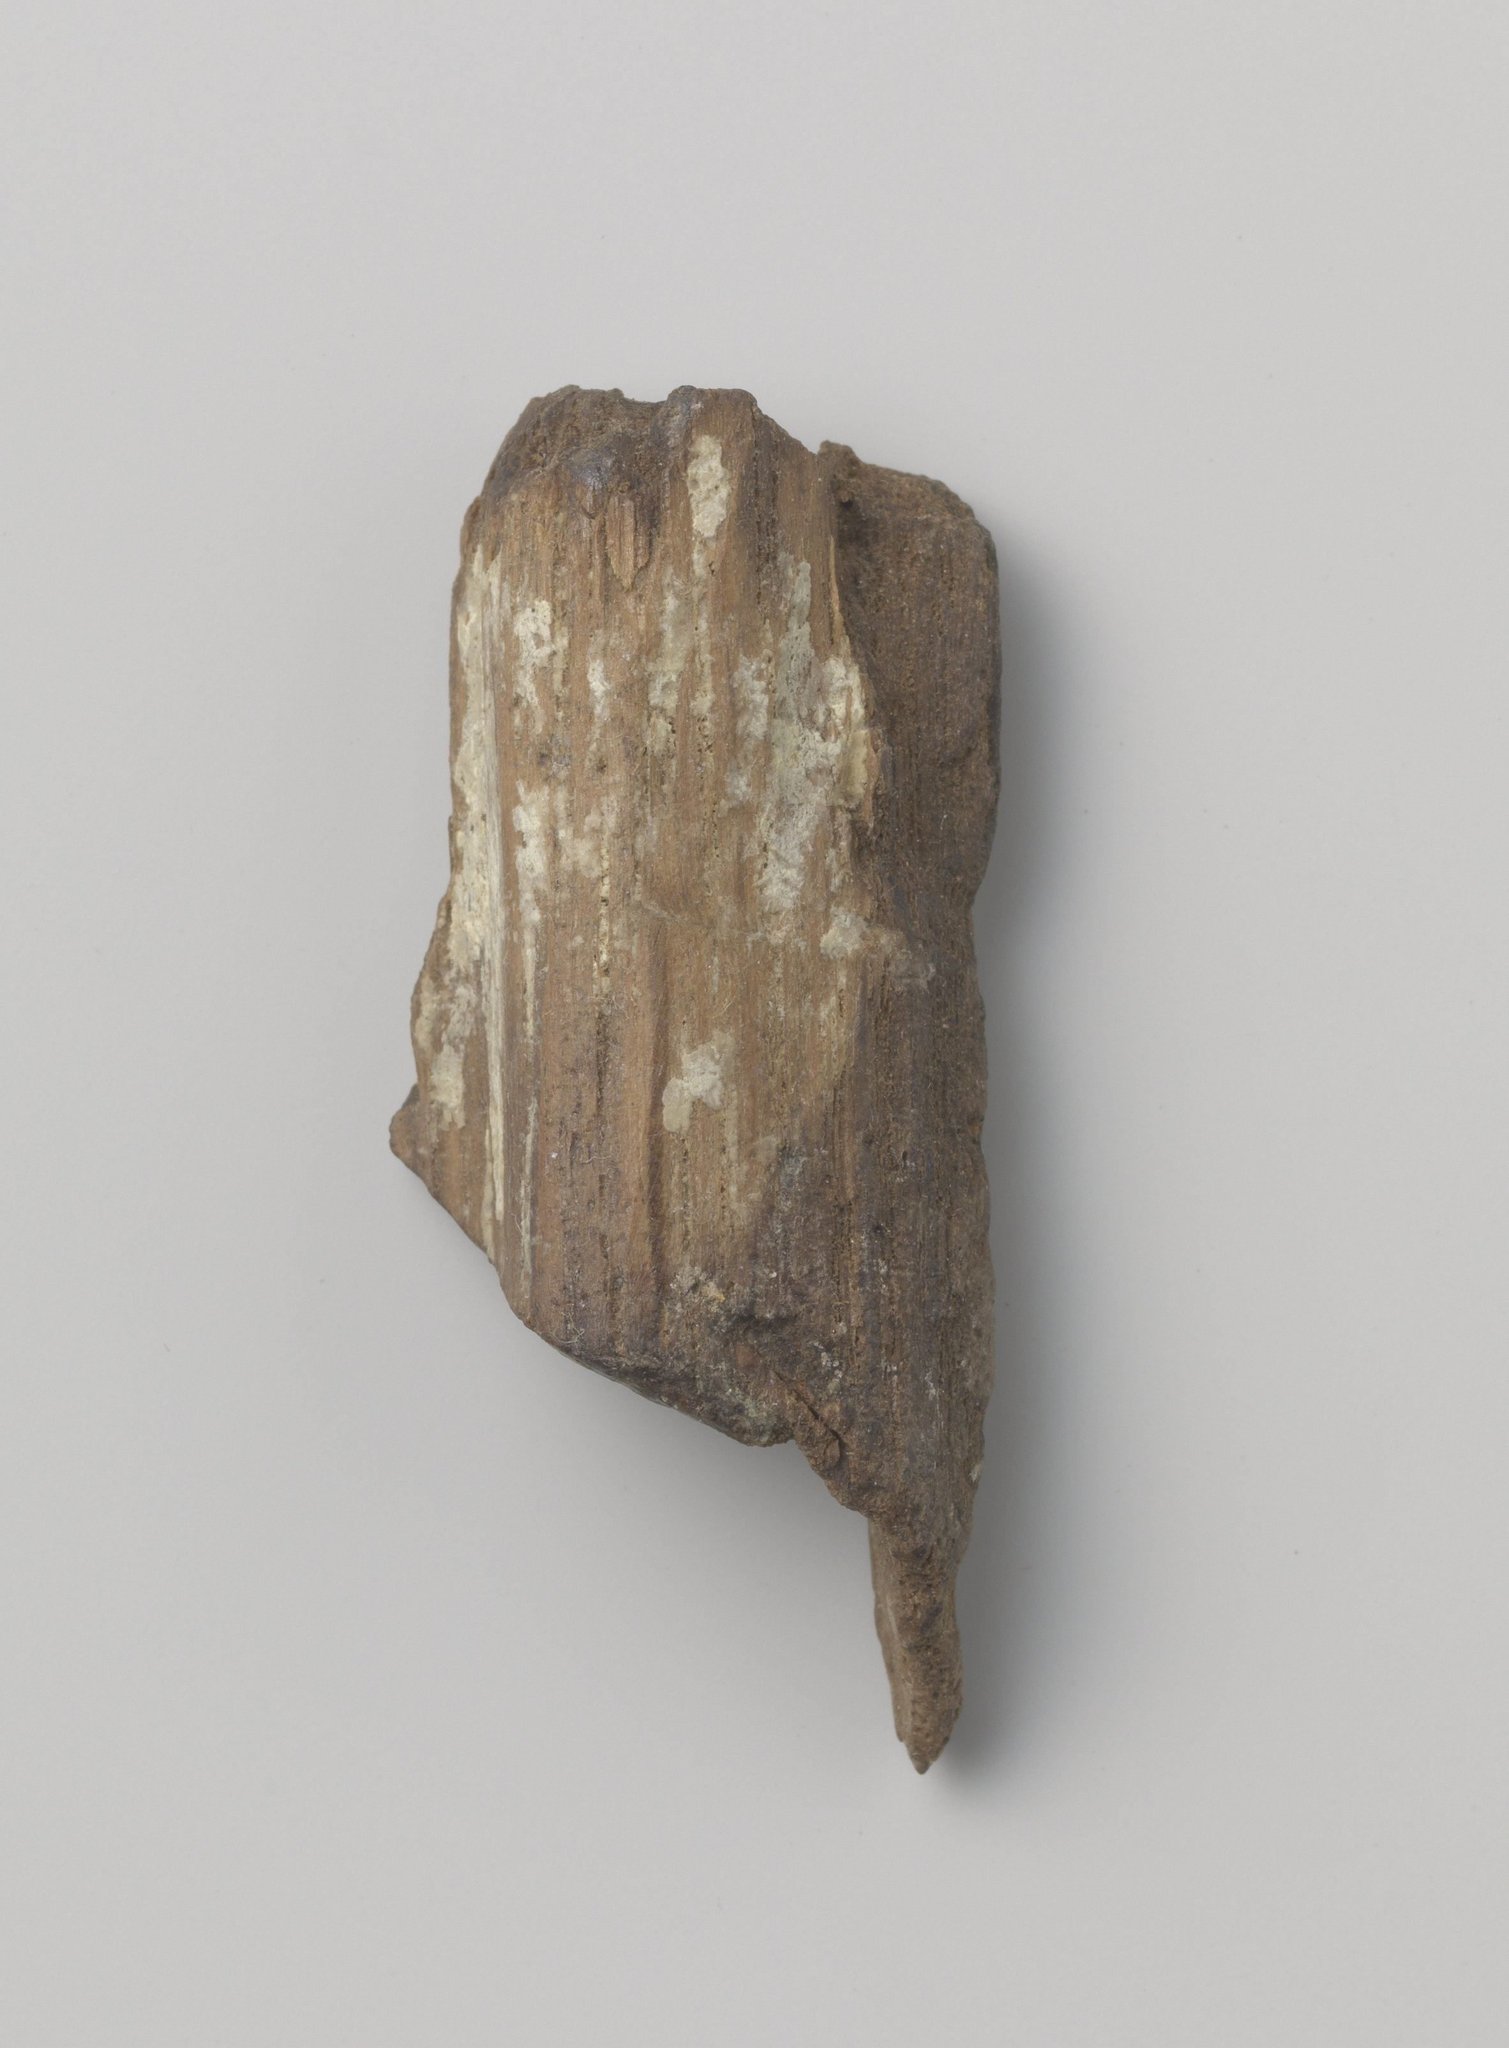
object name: sculpture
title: Fragment; (mogelijk) behorend tot het retabel van Soest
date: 1475-1499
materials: wood